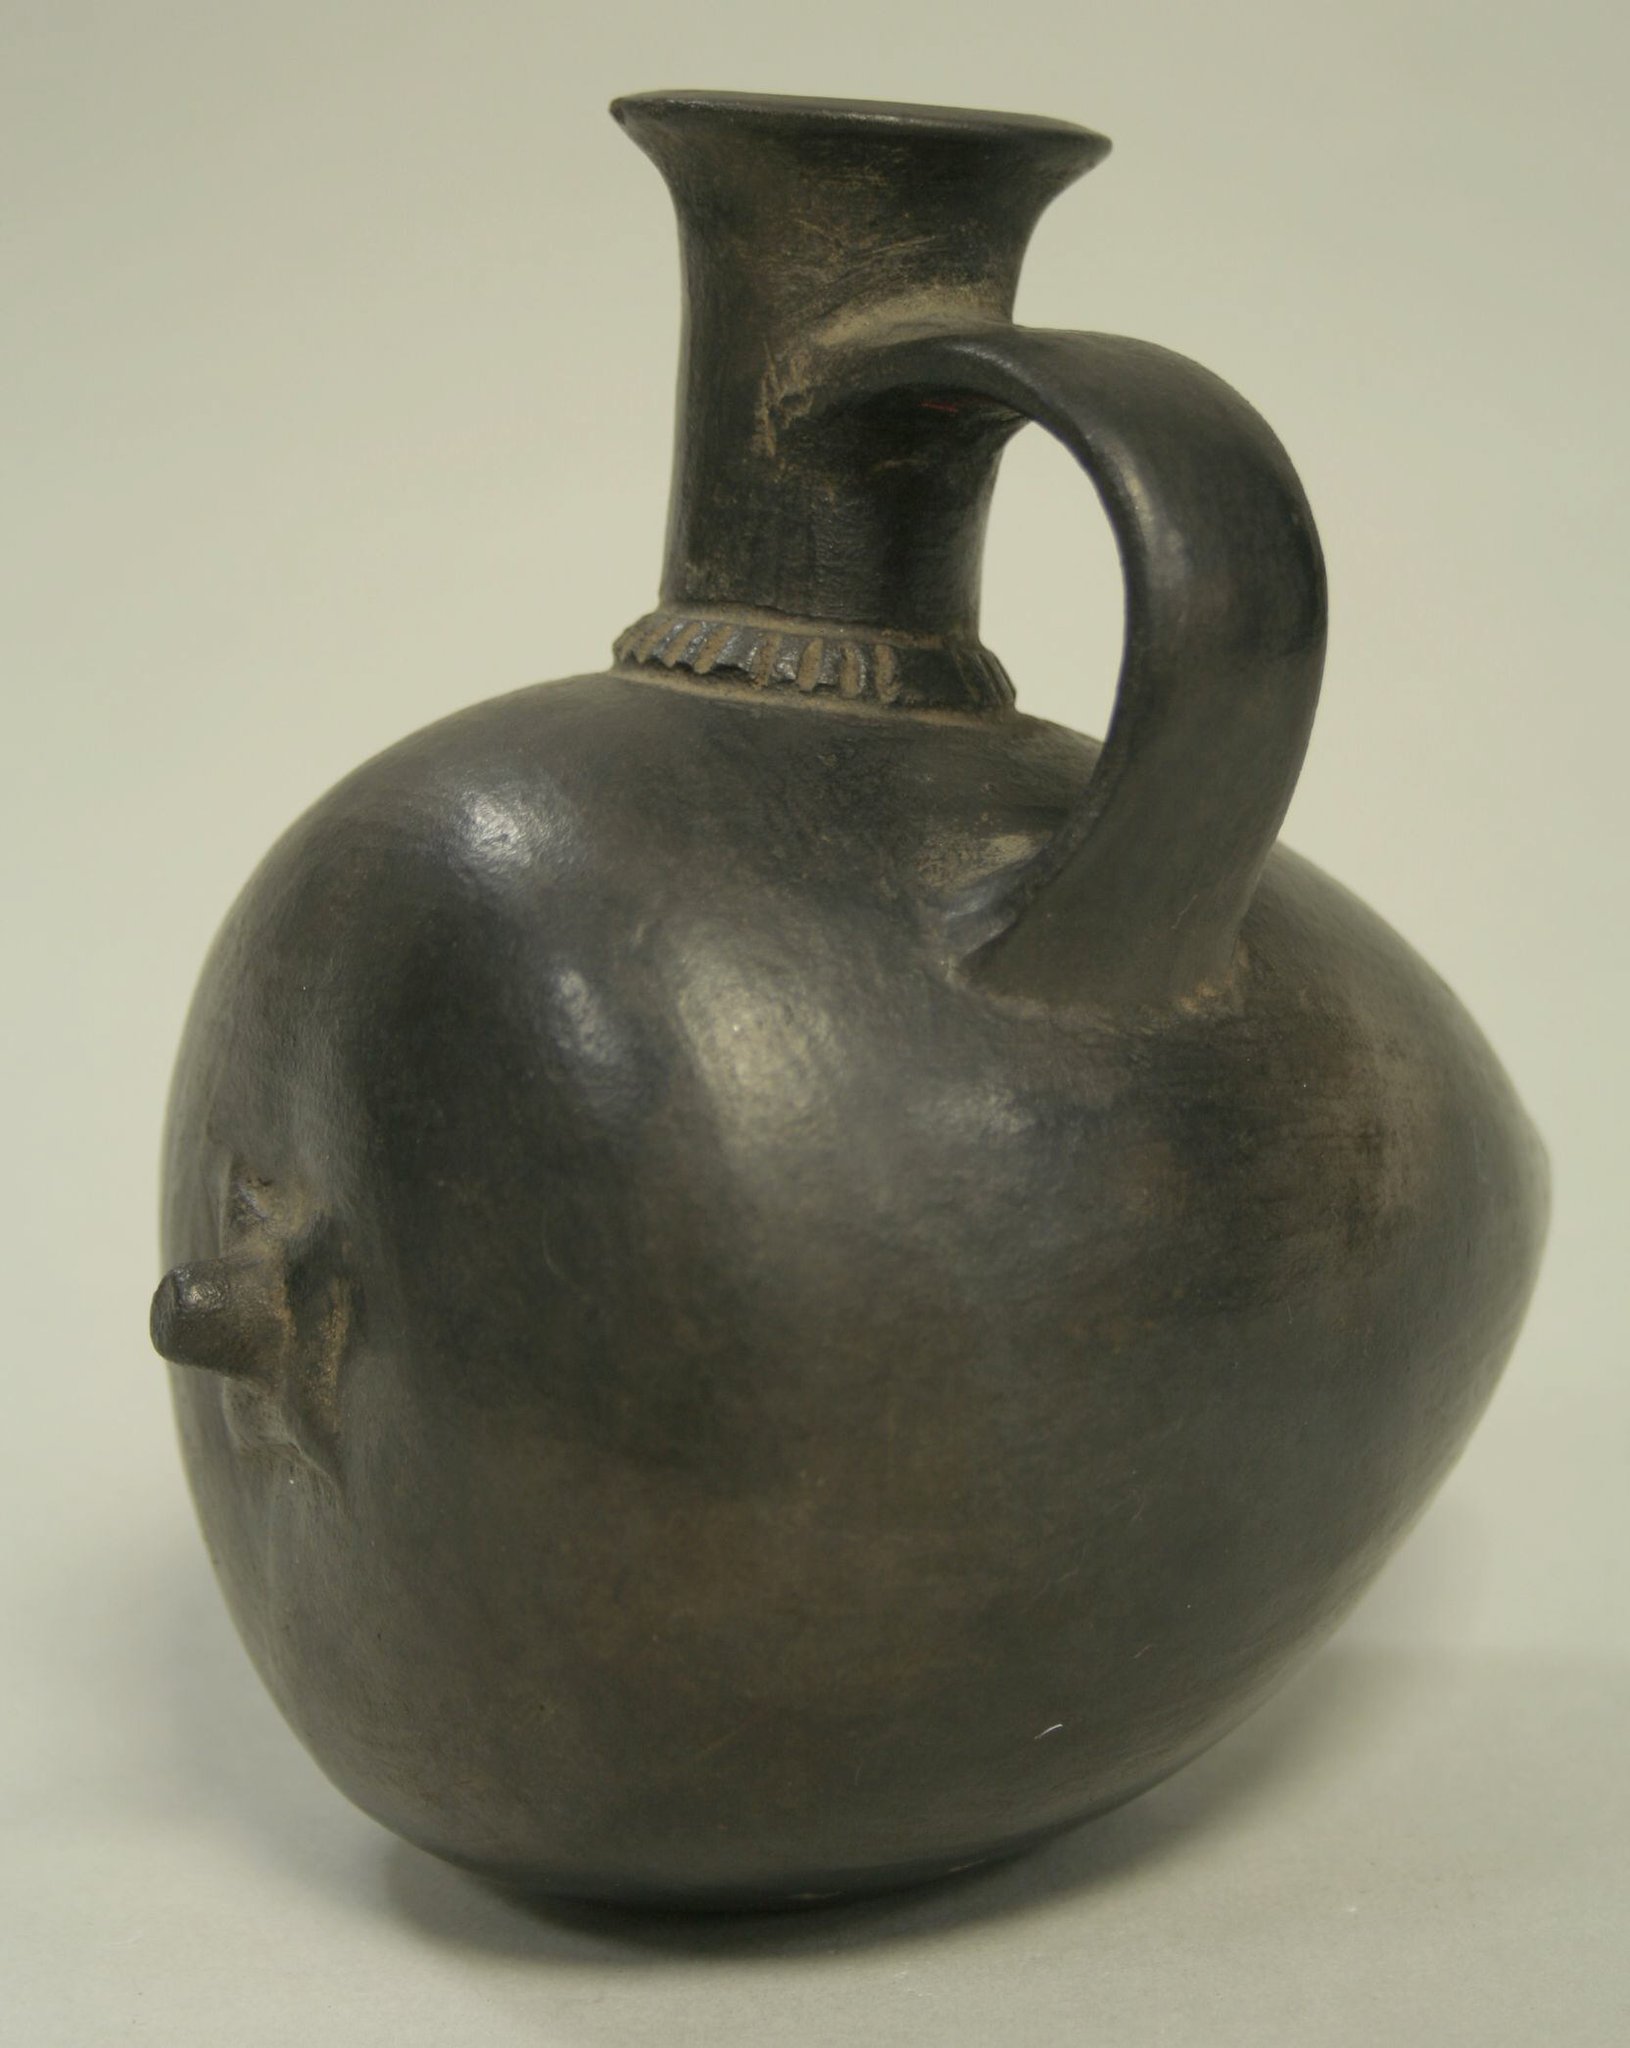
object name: bottle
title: Single Spout Bottle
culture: inca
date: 1401-1600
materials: ceramic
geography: peru